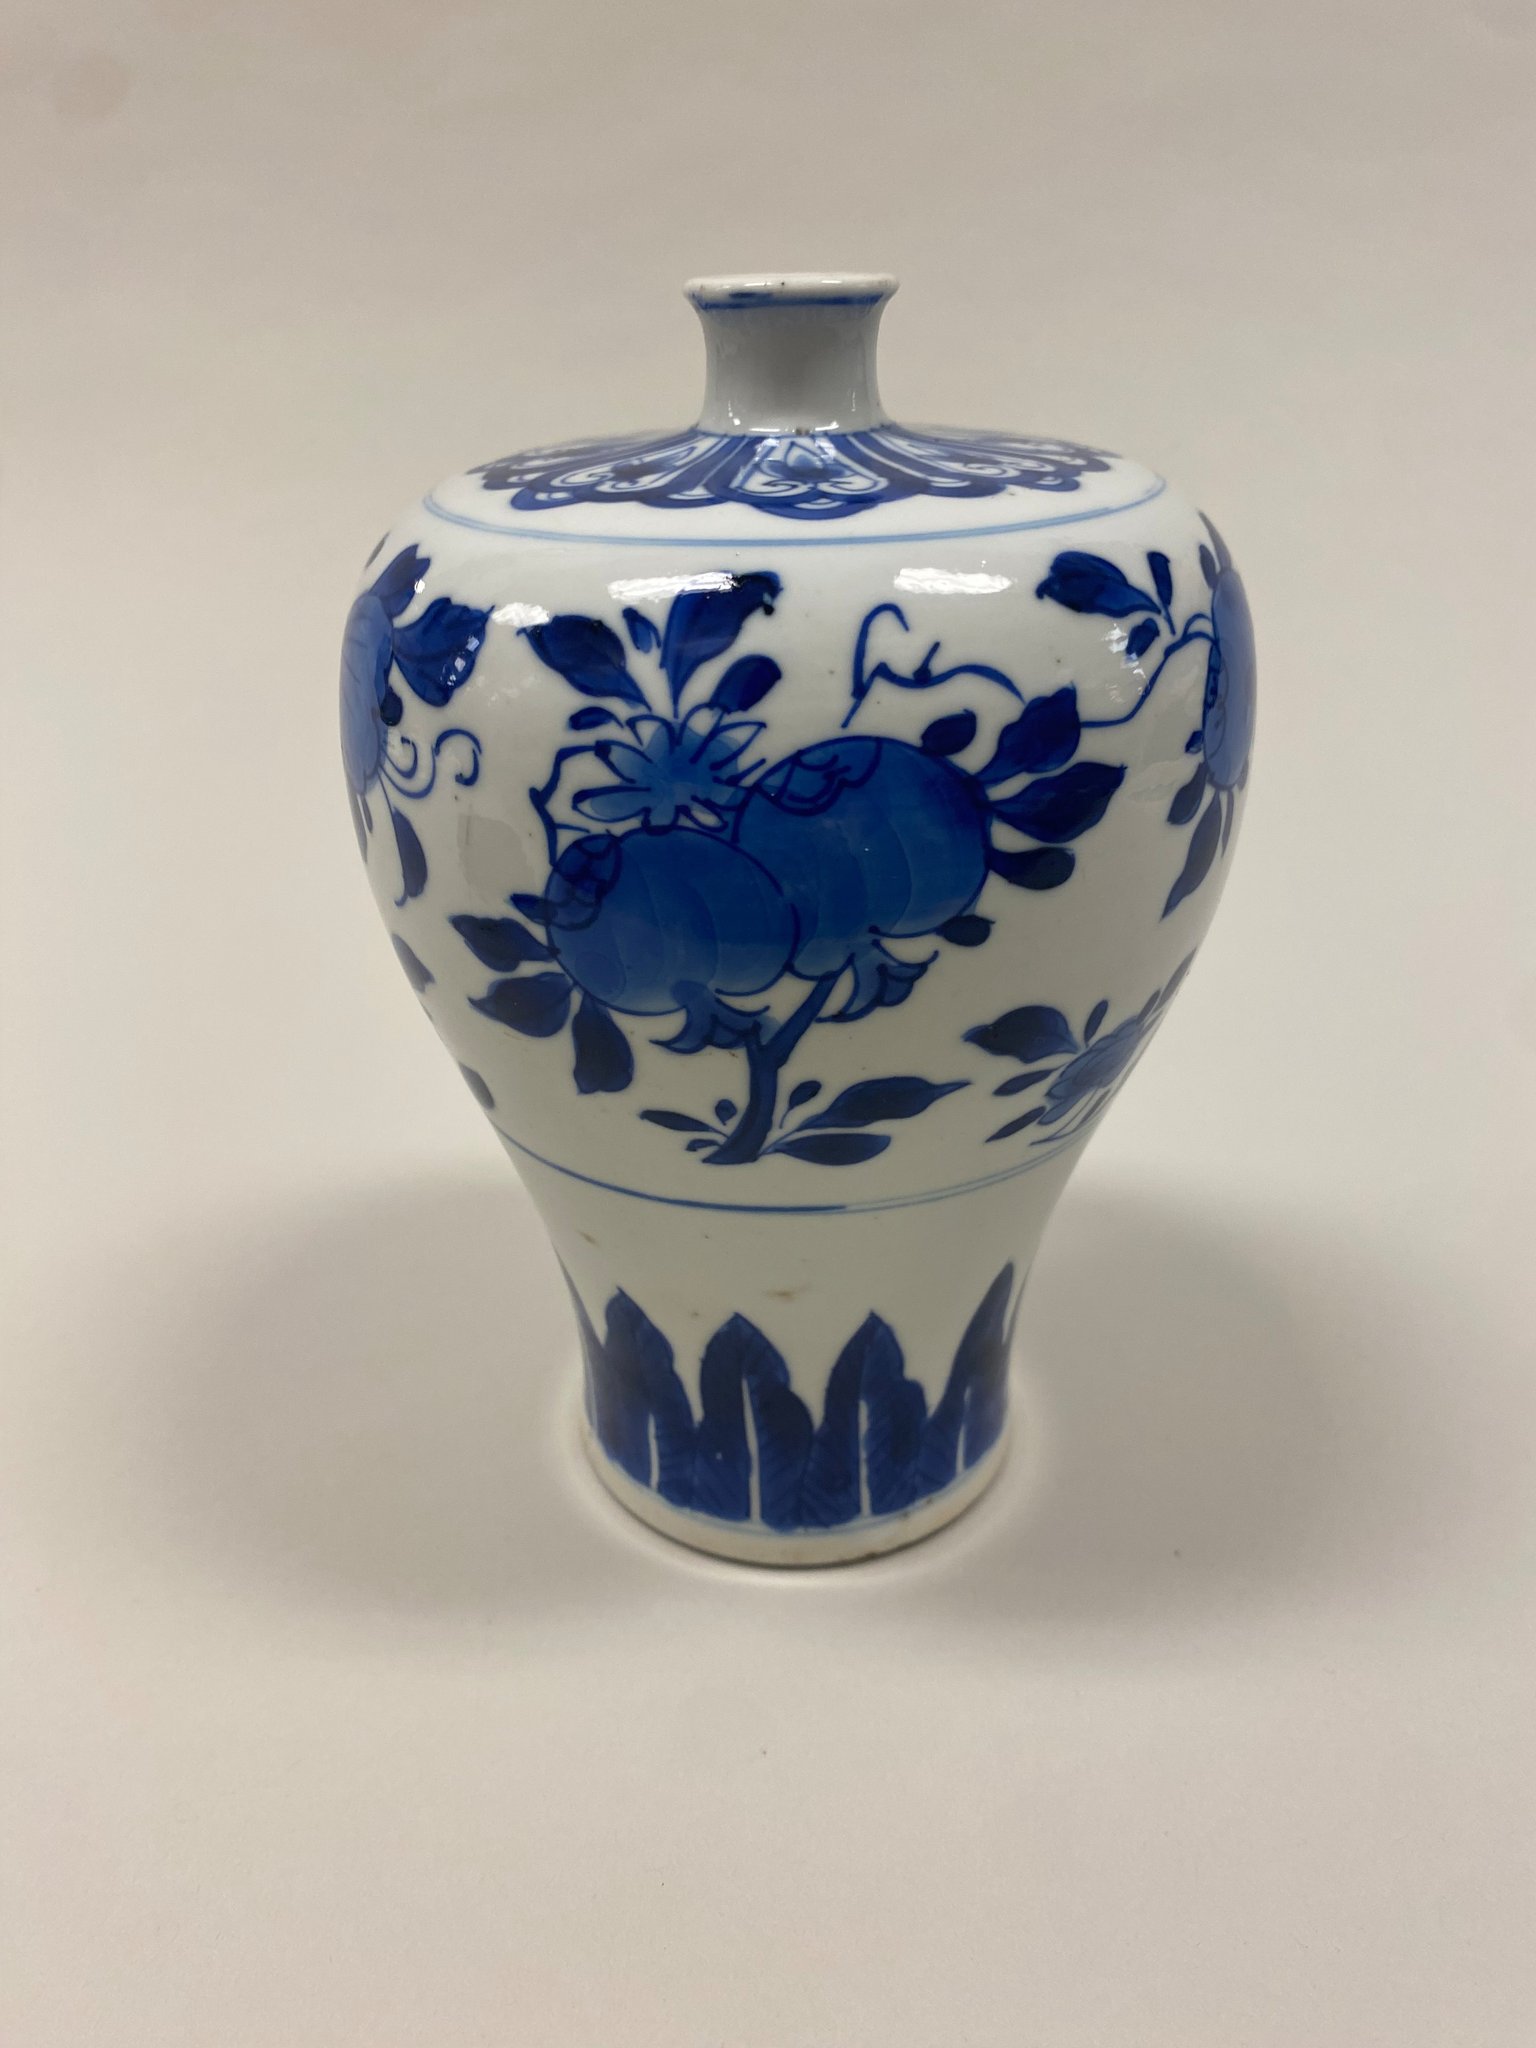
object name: vase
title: Meiping vase with peaches, pomegranades, and fingered citrons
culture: chinese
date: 1667-1733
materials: cobalt, porcelain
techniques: painting, underglaze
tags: fruit,pomegranates